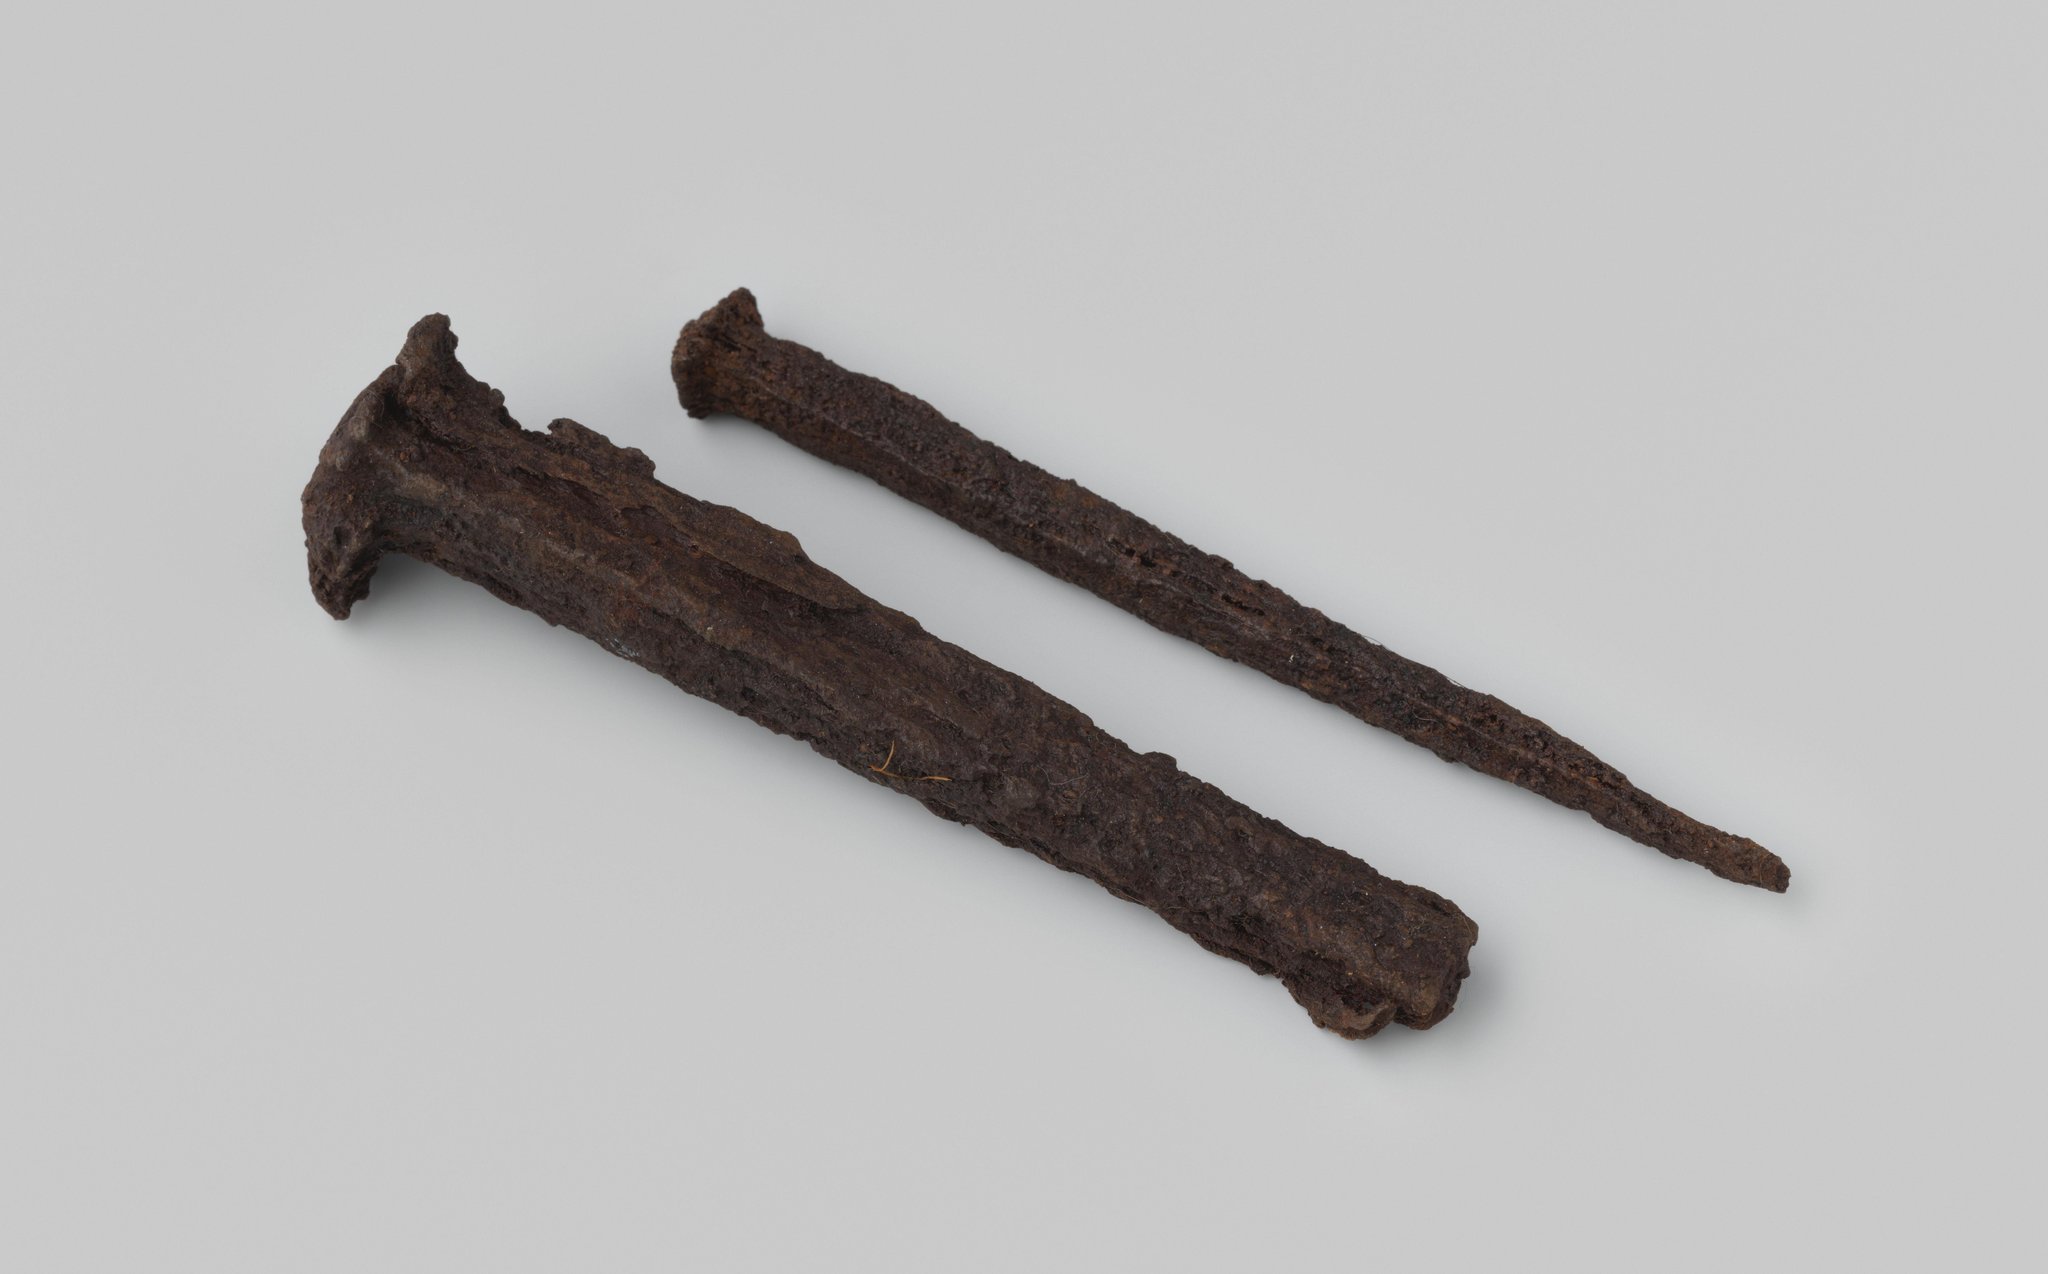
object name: nagel, spijker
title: Spijkers afkomstig uit het wrak van de Oost-Indiëvaarder Hollandia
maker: Anonymous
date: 1700-1743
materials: iron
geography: netherlands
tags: verenigde oostindische compagnie, hollandia (schip)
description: Nails; sim. 80H2347 and fragm, sim. 80H1245, head flat, square.